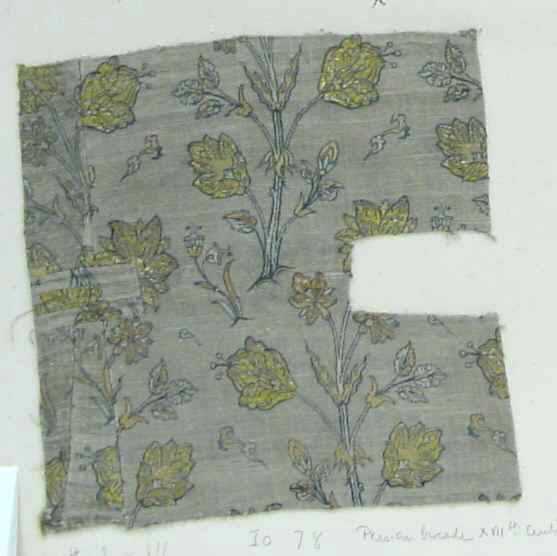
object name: textile fragment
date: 1601-1700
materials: metal thread, silk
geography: iran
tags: flowers